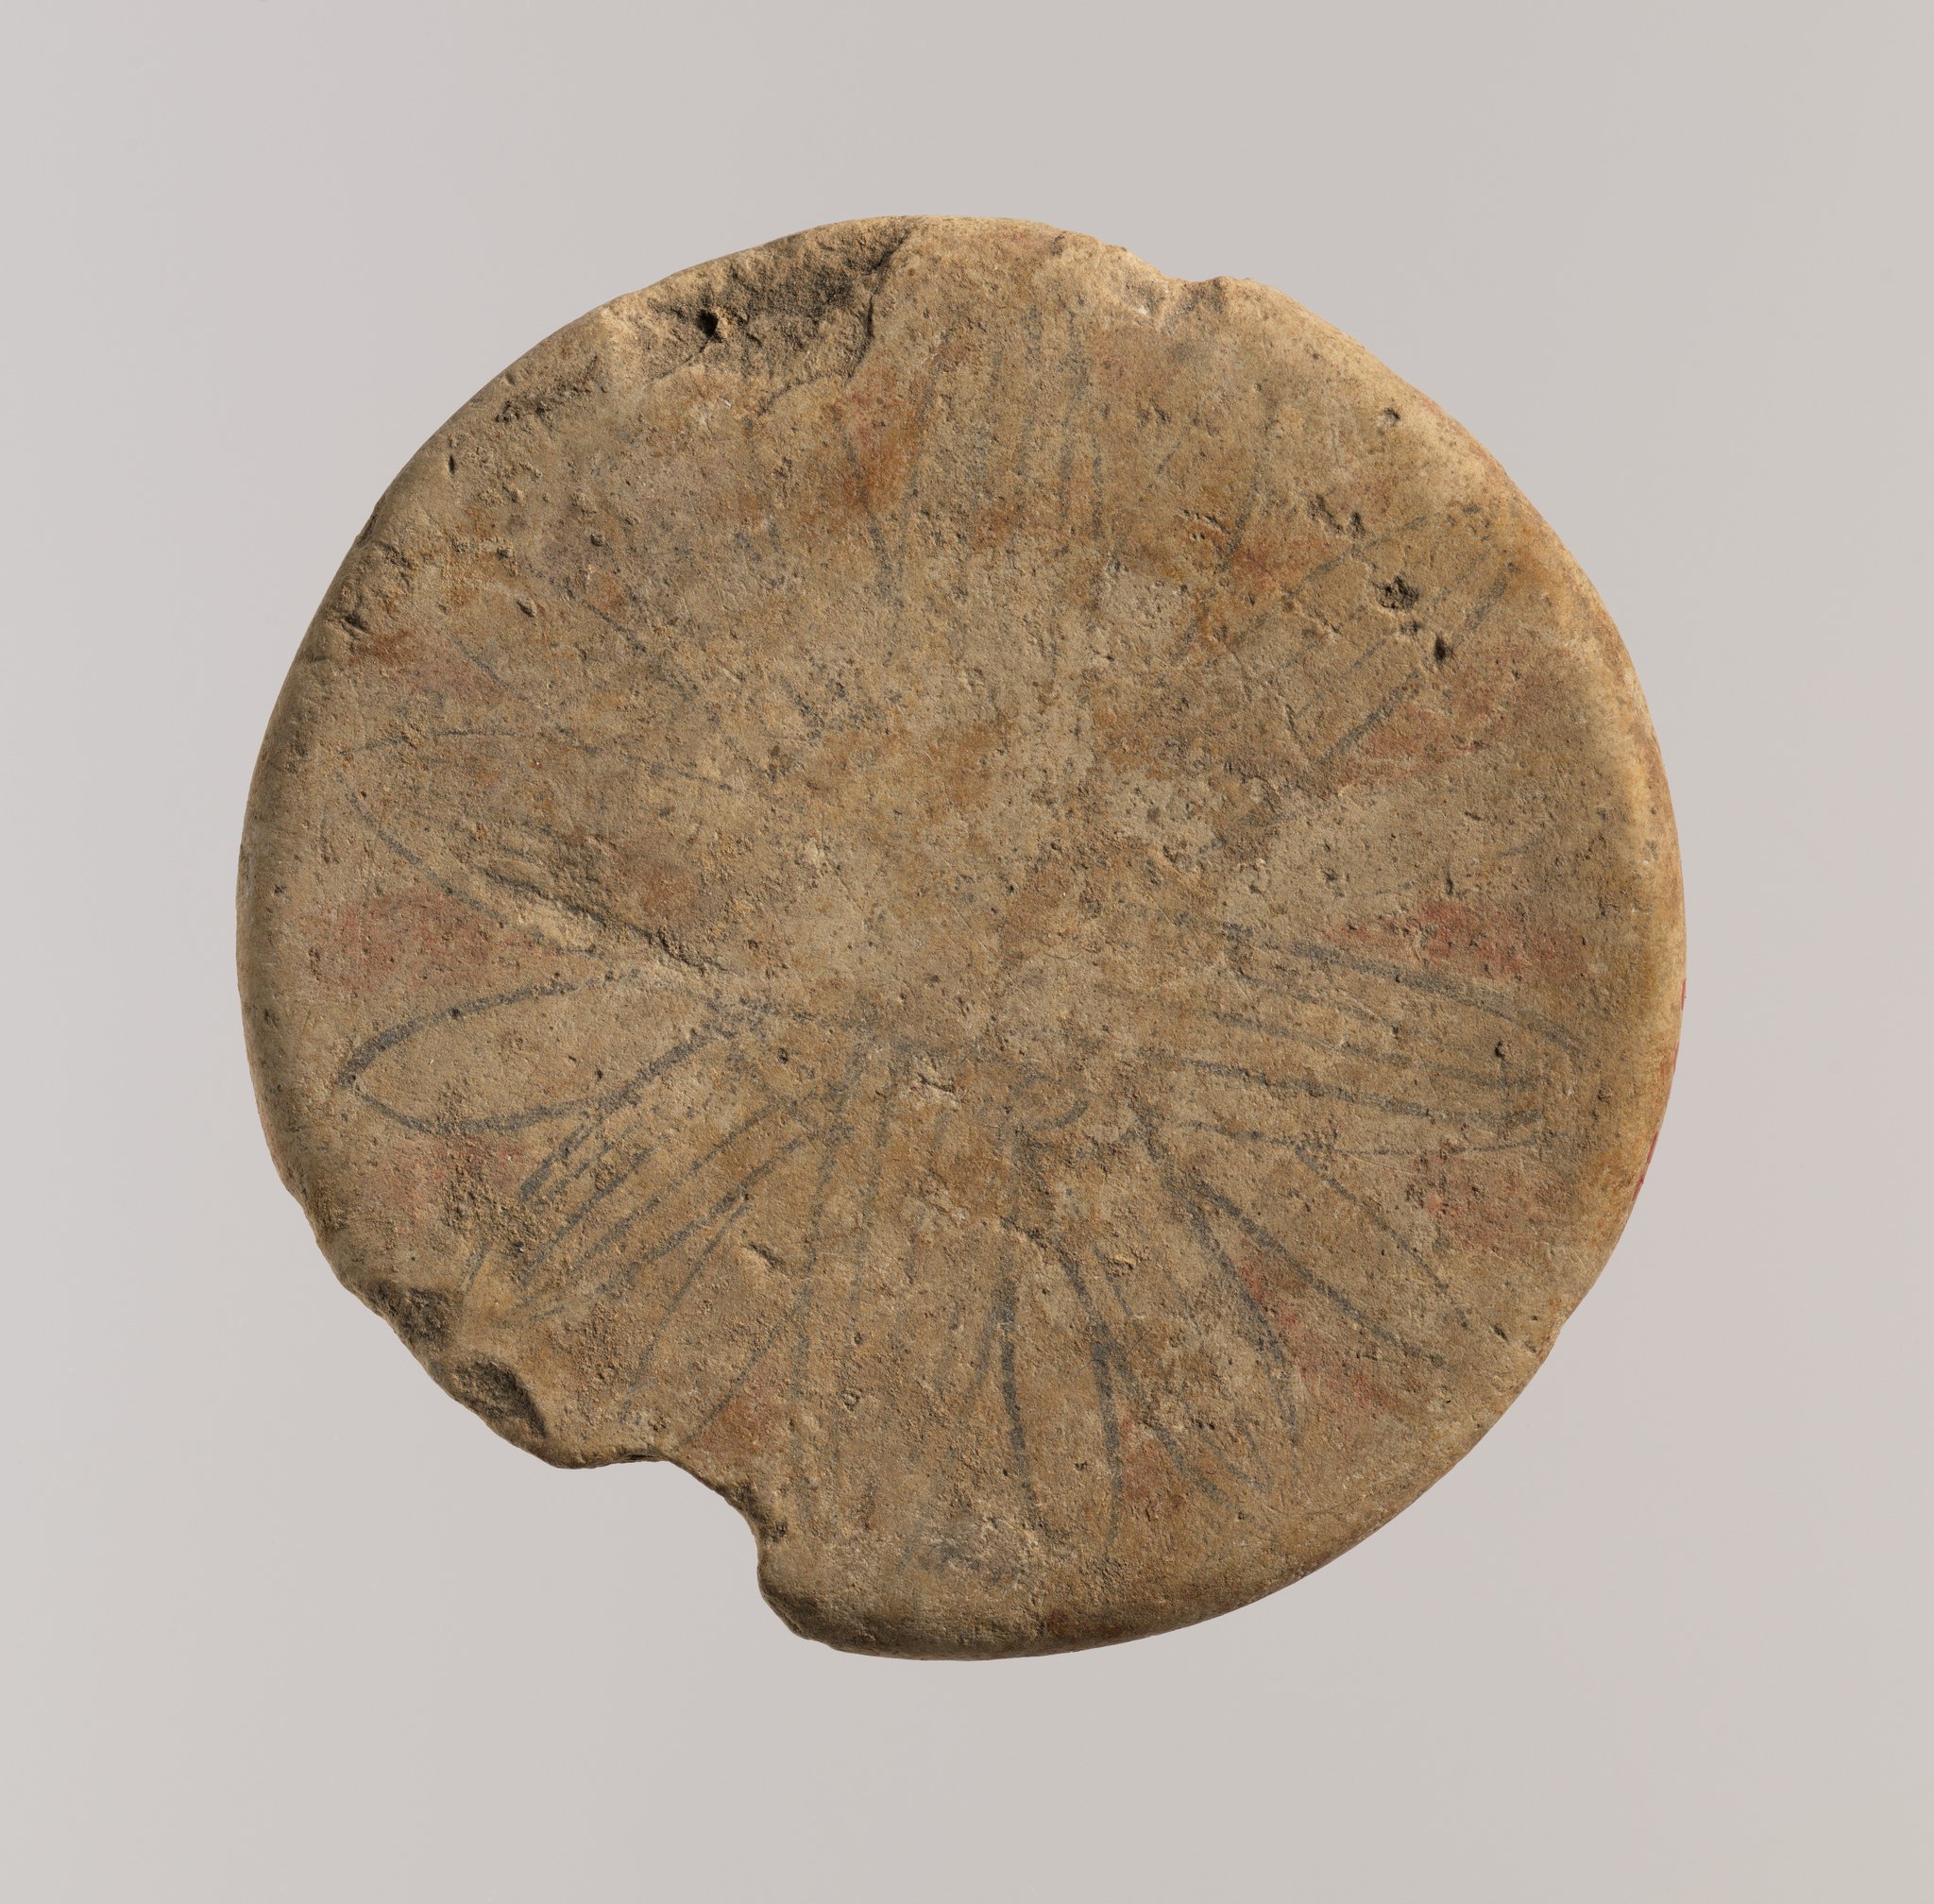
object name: jar with lid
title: Jar lid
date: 712-343 BCE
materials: limestone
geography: egypt